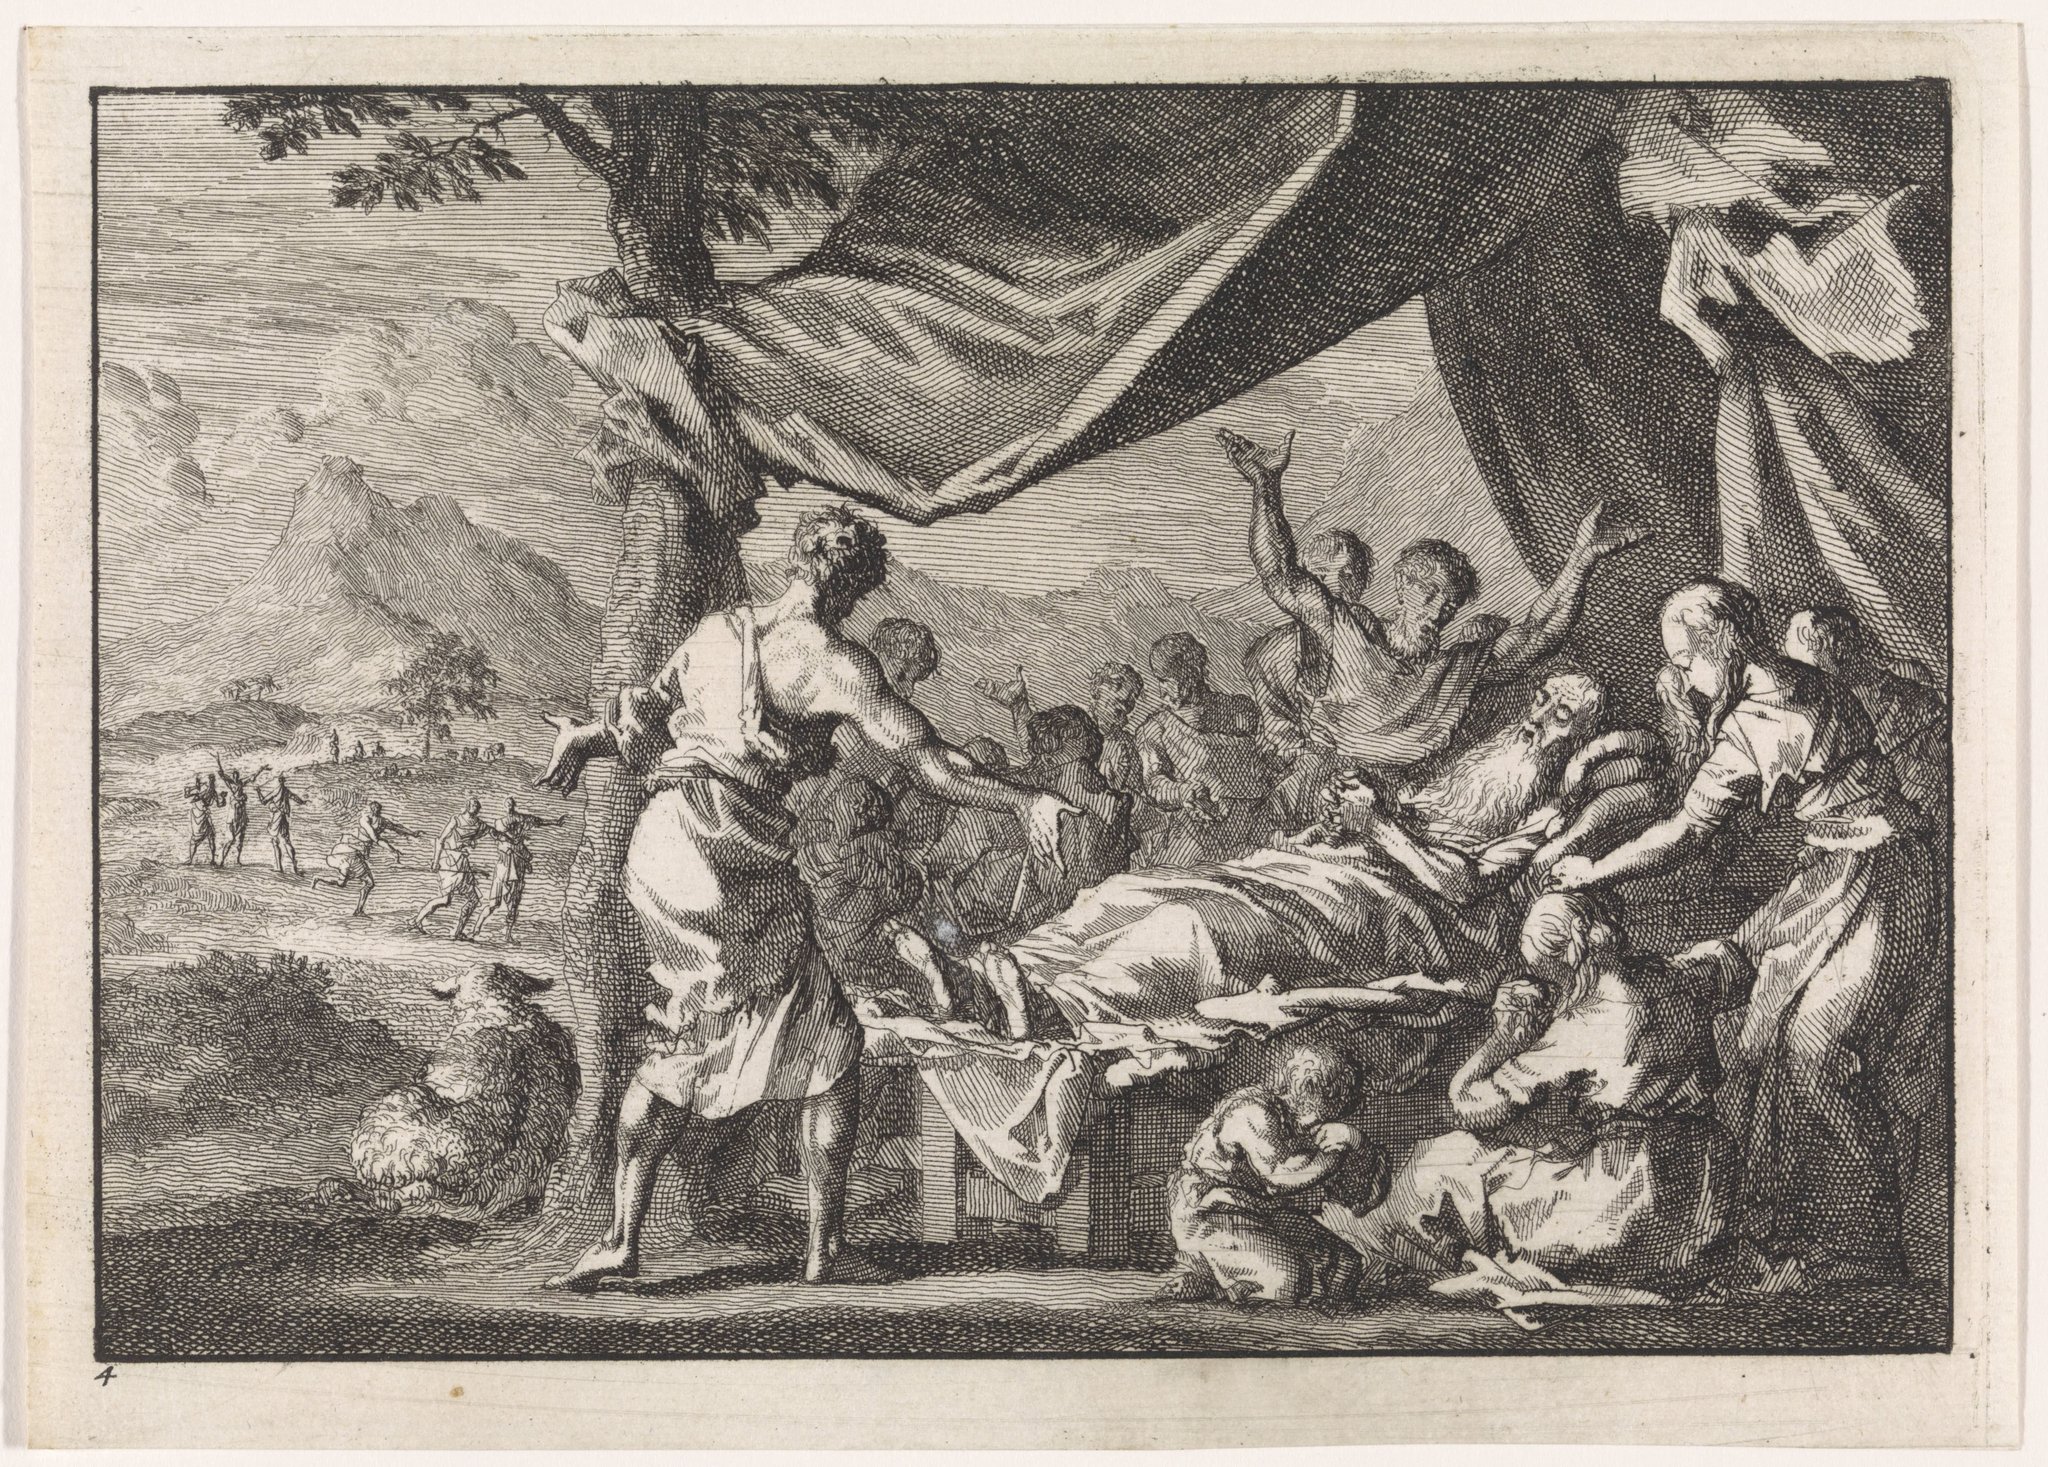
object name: print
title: Adams sterfbed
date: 1703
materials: paper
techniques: etching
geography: amsterdam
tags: death of adam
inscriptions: collector's mark: Lugt 2228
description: Proefdruk voor boekillustratie voor David Martin. Historie des Ouden en Nieuwen Testaments. Amsterdam, Pieter Mortier, 1703. Deel I. De boekillustraties voor de Mortierbijbel hebben verschillende staten en kopieën, waarbij de chronologische volgorde moeilijk te achterhalen valt. Als boekillustraties werden ze bovendien herhaaldelijk opnieuw gebruikt voor andere boekwerken.